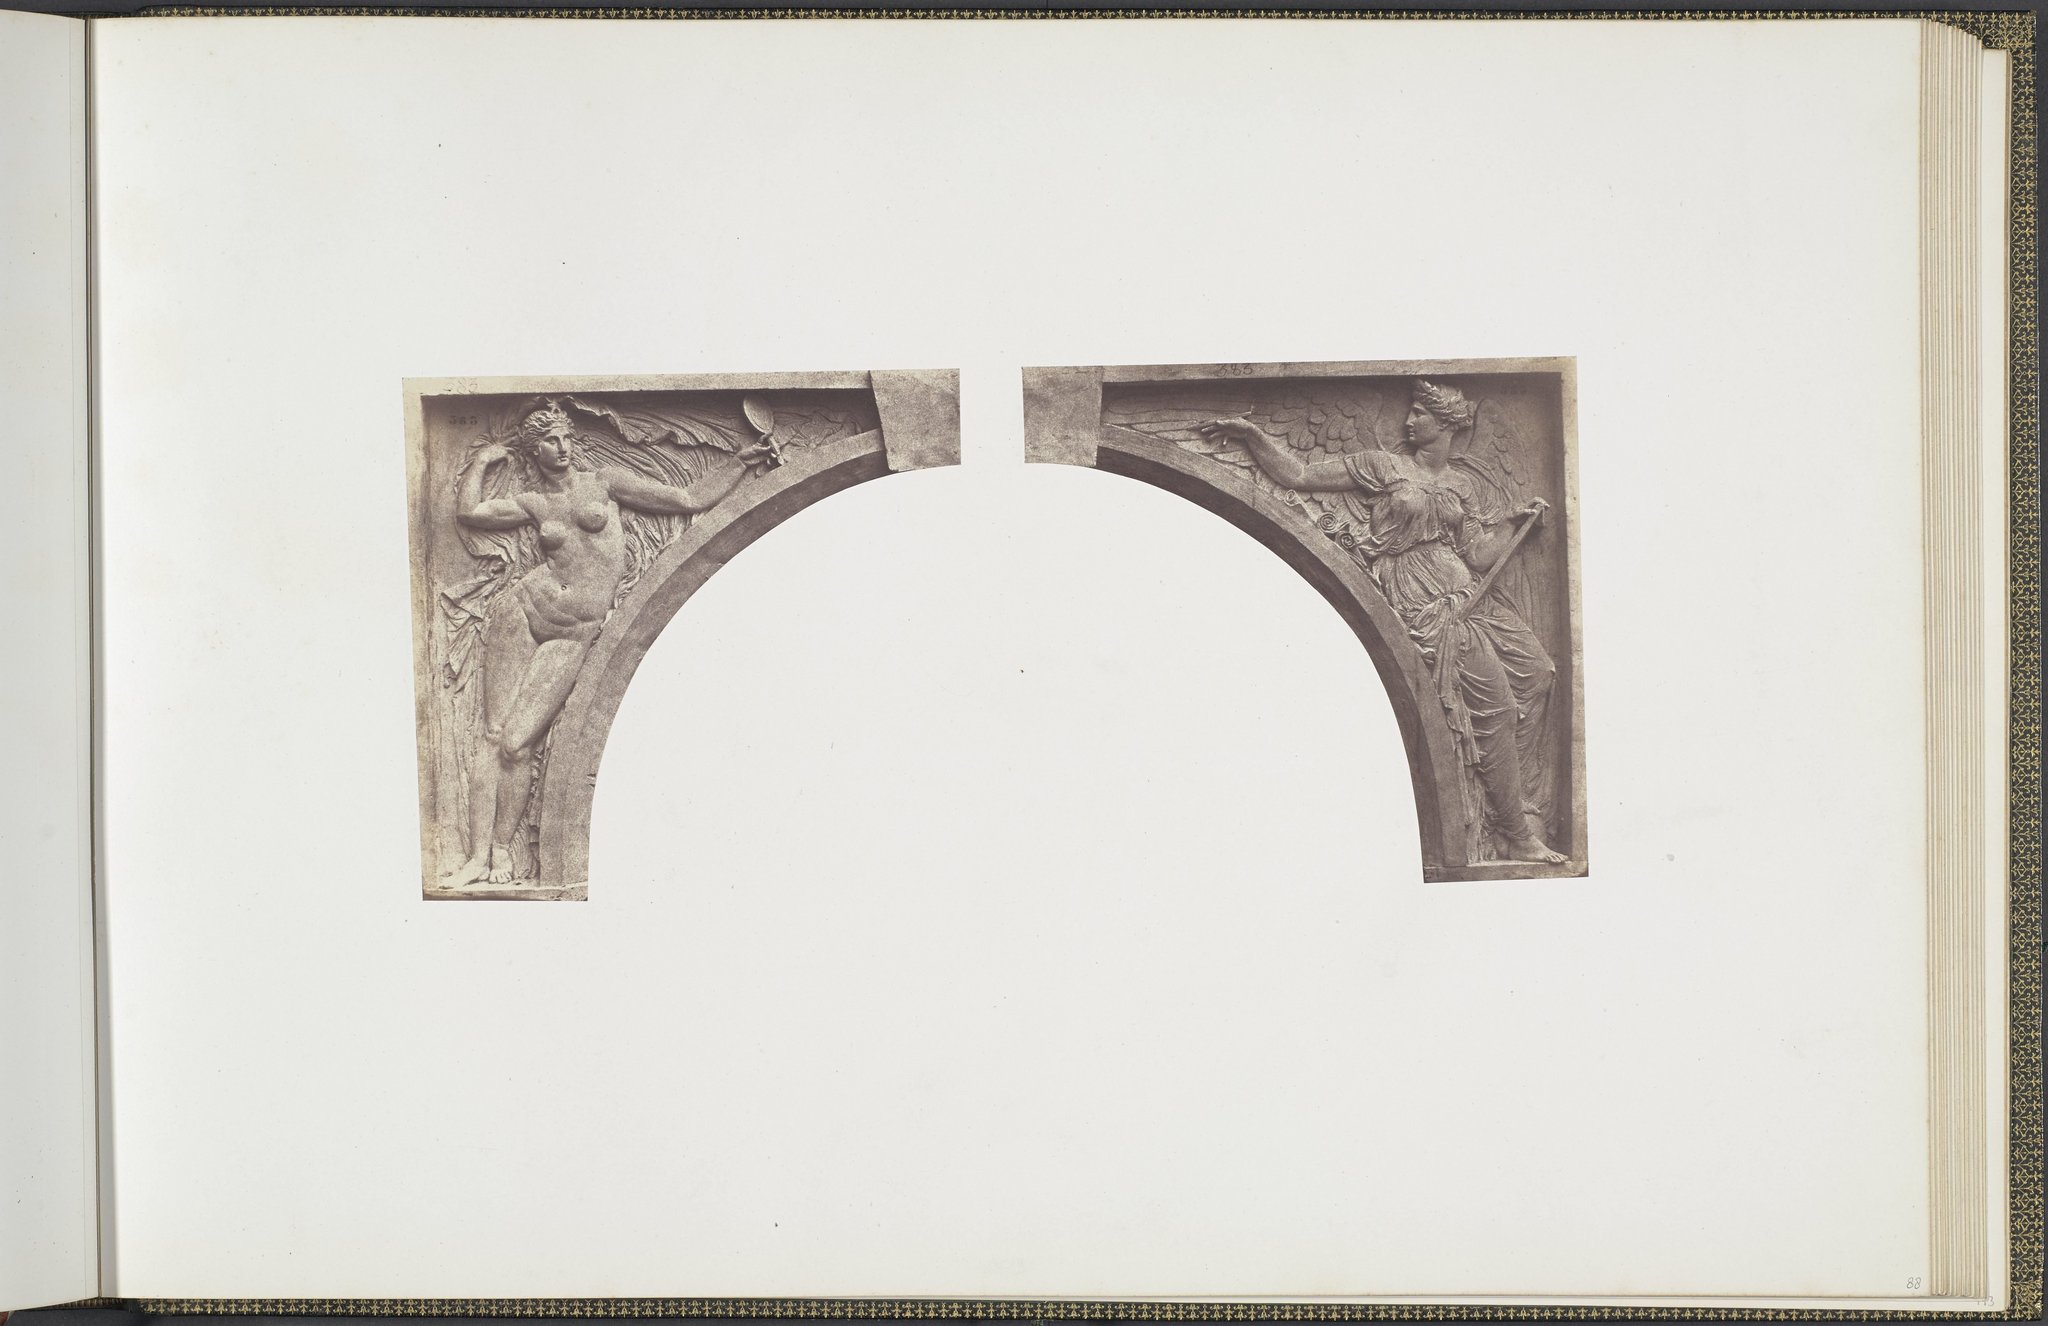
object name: photograph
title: Gipsmodellen voor beeldhouwwerken op het Palais du Louvre: "La Vérité et l'Histoire" door Joseph Félon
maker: édouard denis baldus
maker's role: fotograaf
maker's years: 1813-1889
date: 1855-1857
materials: paper, photographic support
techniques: salted paper print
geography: paris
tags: piece of sculpture, reproduction of a piece of sculpture, permanent exhibition, museum, paris, tuileries palace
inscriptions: number: ‘383’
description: Onderdeel van Réunion des Tuileries au Louvre 1852-1857, album 1.